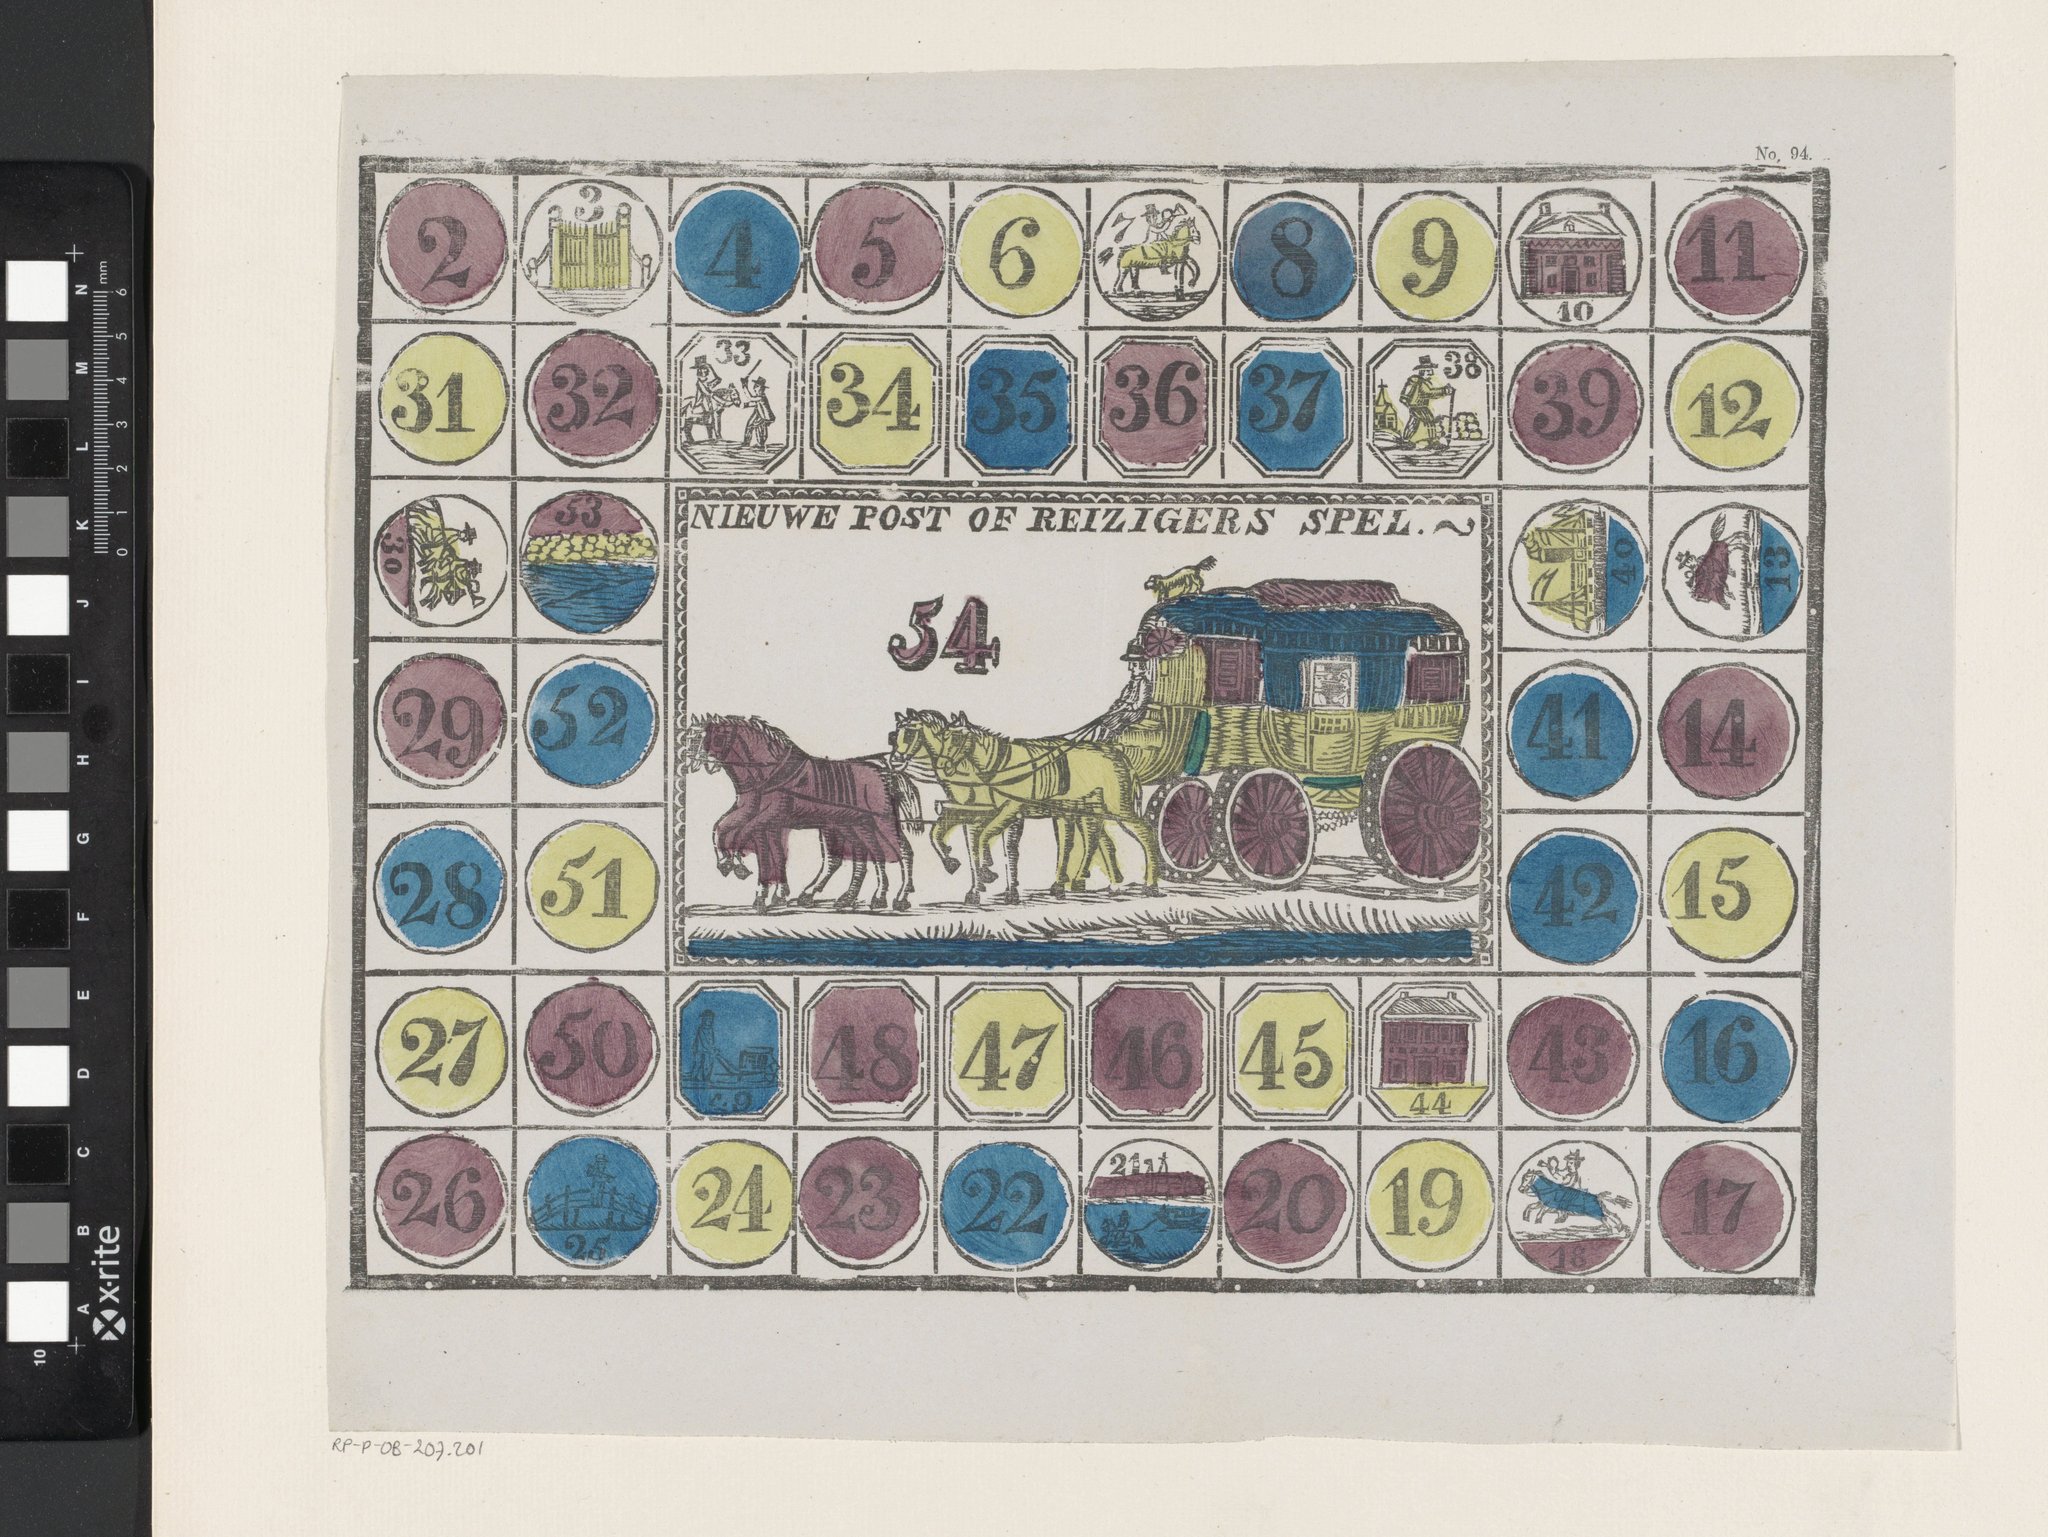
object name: print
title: Nieuwe post of reizigers spel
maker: Anonymous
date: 1848-1881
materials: paper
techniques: colour, letterpress printing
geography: den bosch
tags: board-games of chance, four-wheeled, animal-drawn vehicle, e.g.: cab, carriage, coach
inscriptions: collector's mark: Lugt 2760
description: Rechthoekig borspel met vakjes genummerd van 2 tot 54. Vakje 54 is groter en toont een rijtuig voortgetrokken door vier paarden. Genummerd rechtsboven: No. 94.